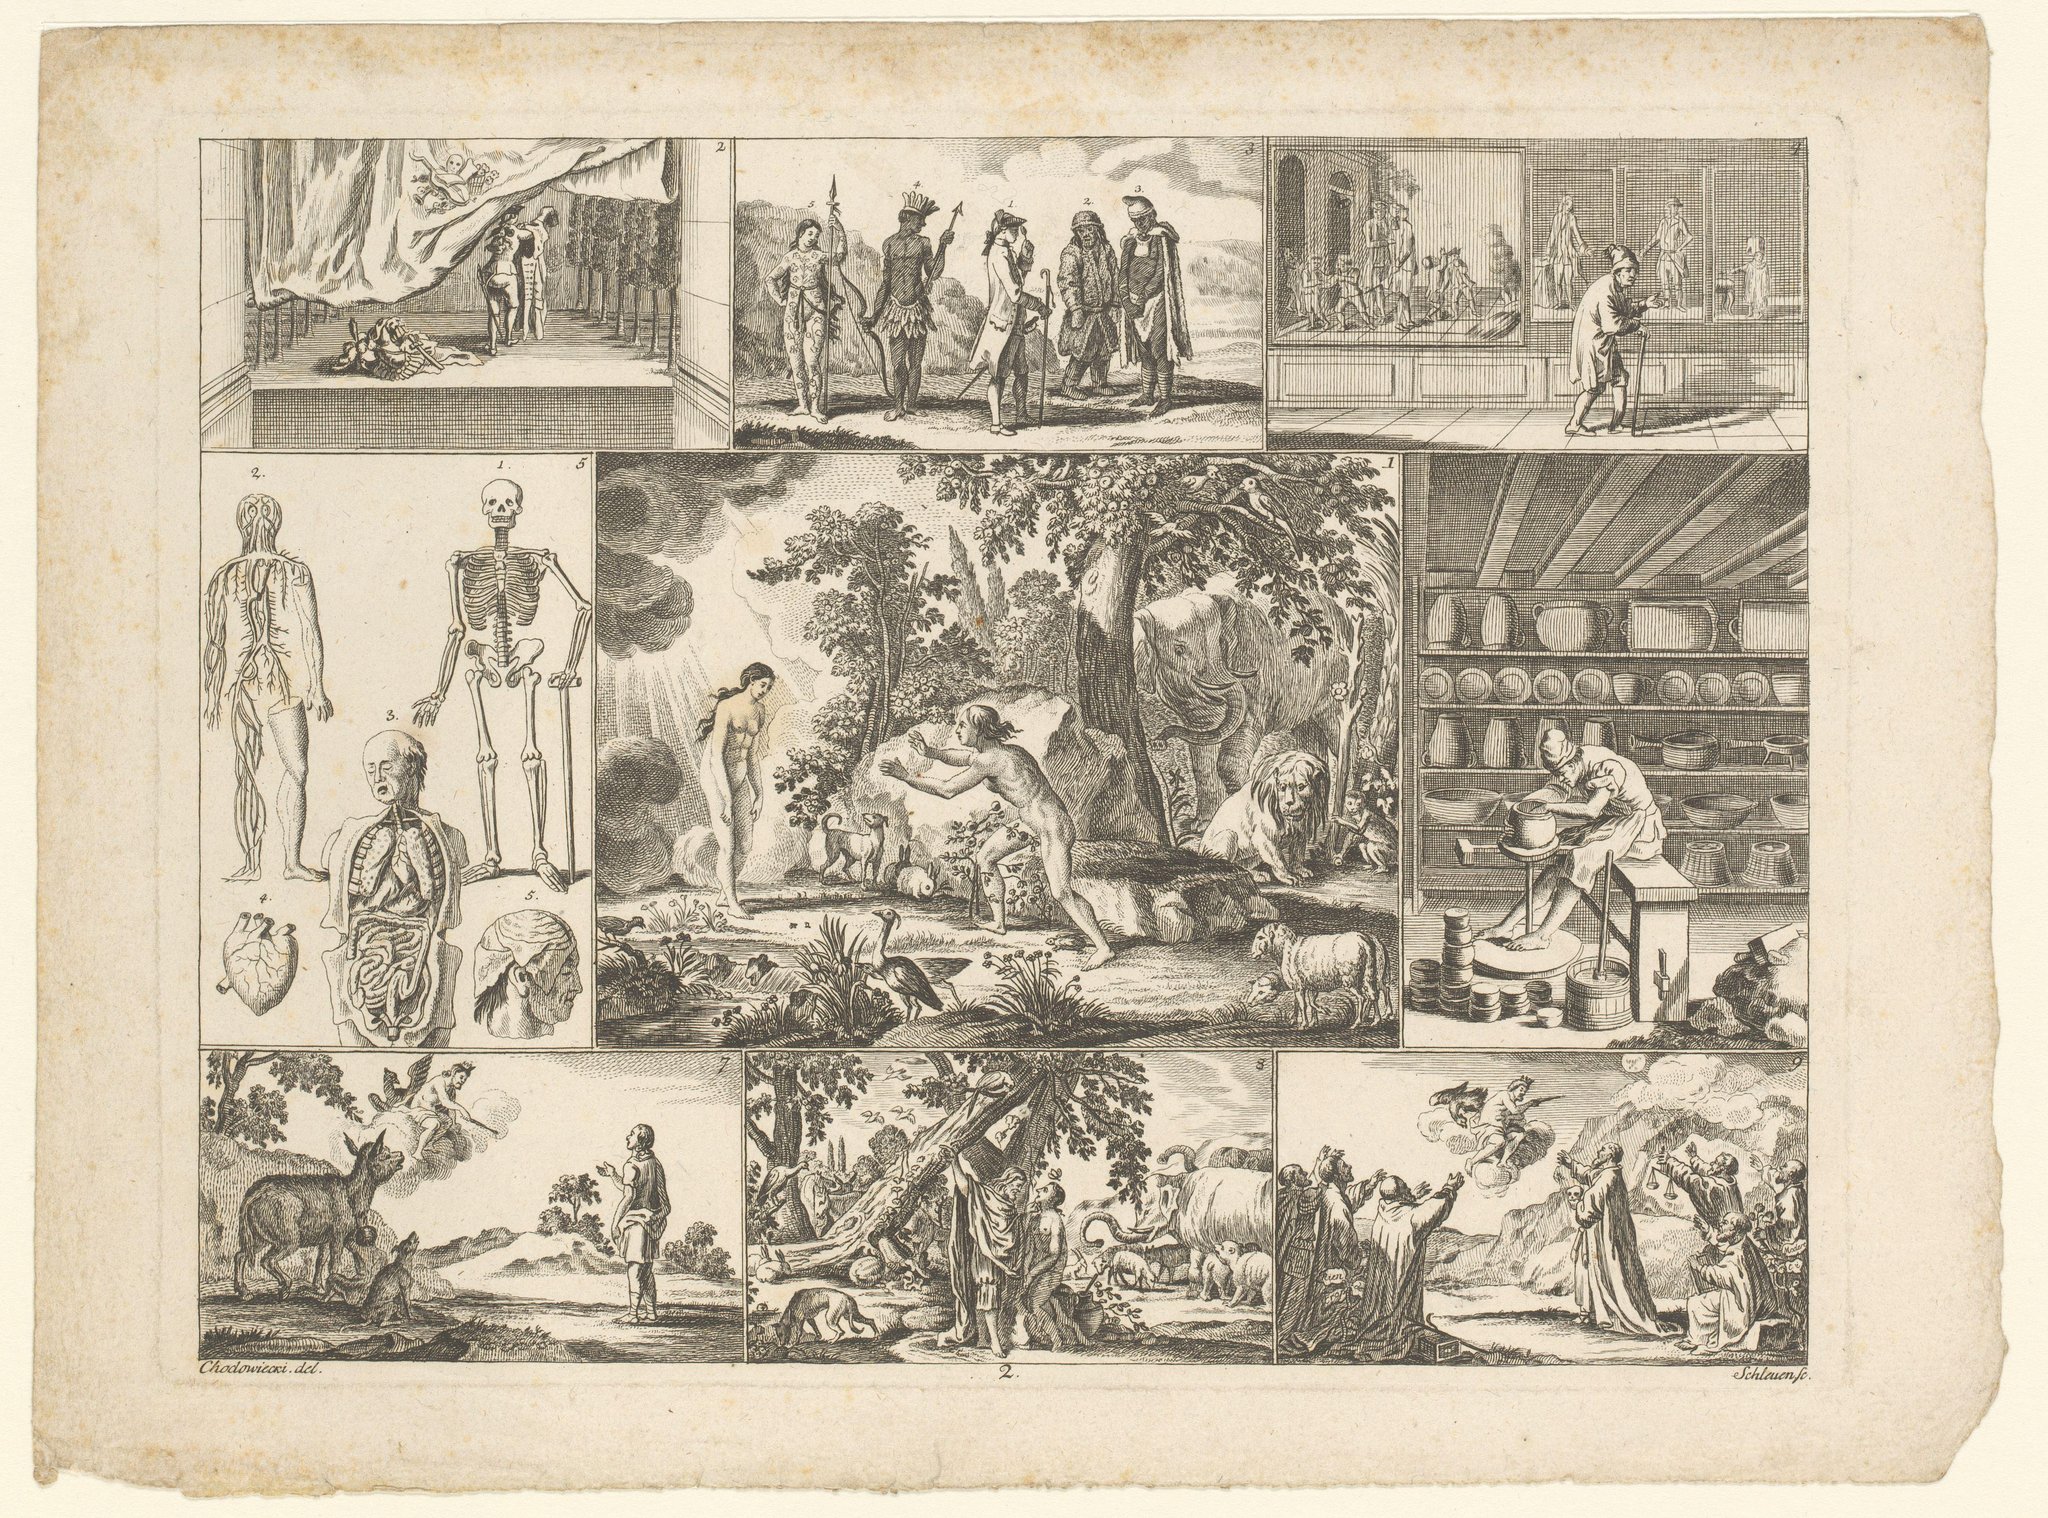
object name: print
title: Adam en Eva in het paradijs, omringd door uiteenlopende voorstellingen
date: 1784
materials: paper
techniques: engraving, etching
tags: physiology and anatomy, potter, ceramist, temptation and fall: adam and eve in paradise (after the fall) (genesis 3:8-21)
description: Maakt deel uit van een serie encyclopedische prenten door verschillende kunstenaars naar ontwerp van Daniel Nikolaus Chodowiecki bij Johann Sigmund Stoy's 'Bilder-Akademie für die Jugend', uitgegeven te Neurenberg in 1784. De prenten waren bedoeld voor kinderen om uit te knippen, op kaarten te plakken en vervolgens op logische wijze te rangschikken (zie Heesen, Anke te. The World in a Box: The Story of an Eighteenth-Century Picture Encyclopedia. Chicago: University of Chicago Press, 2002).